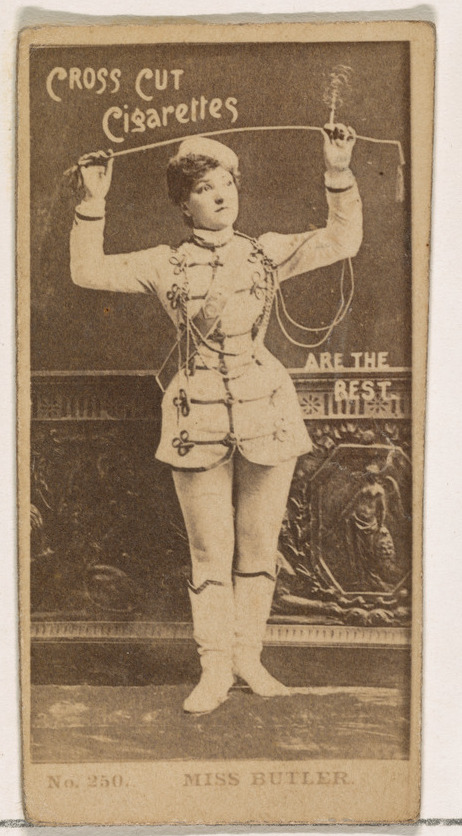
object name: print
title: Card Number 250, Miss Butler, from the Actors and Actresses series (N145-2) issued by Duke Sons & Co. to promote Cross Cut Cigarettes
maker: w. duke, sons & co.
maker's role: publisher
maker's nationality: american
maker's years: 1870-1920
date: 1880-1889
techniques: albumen silver print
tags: portraits,women,actresses